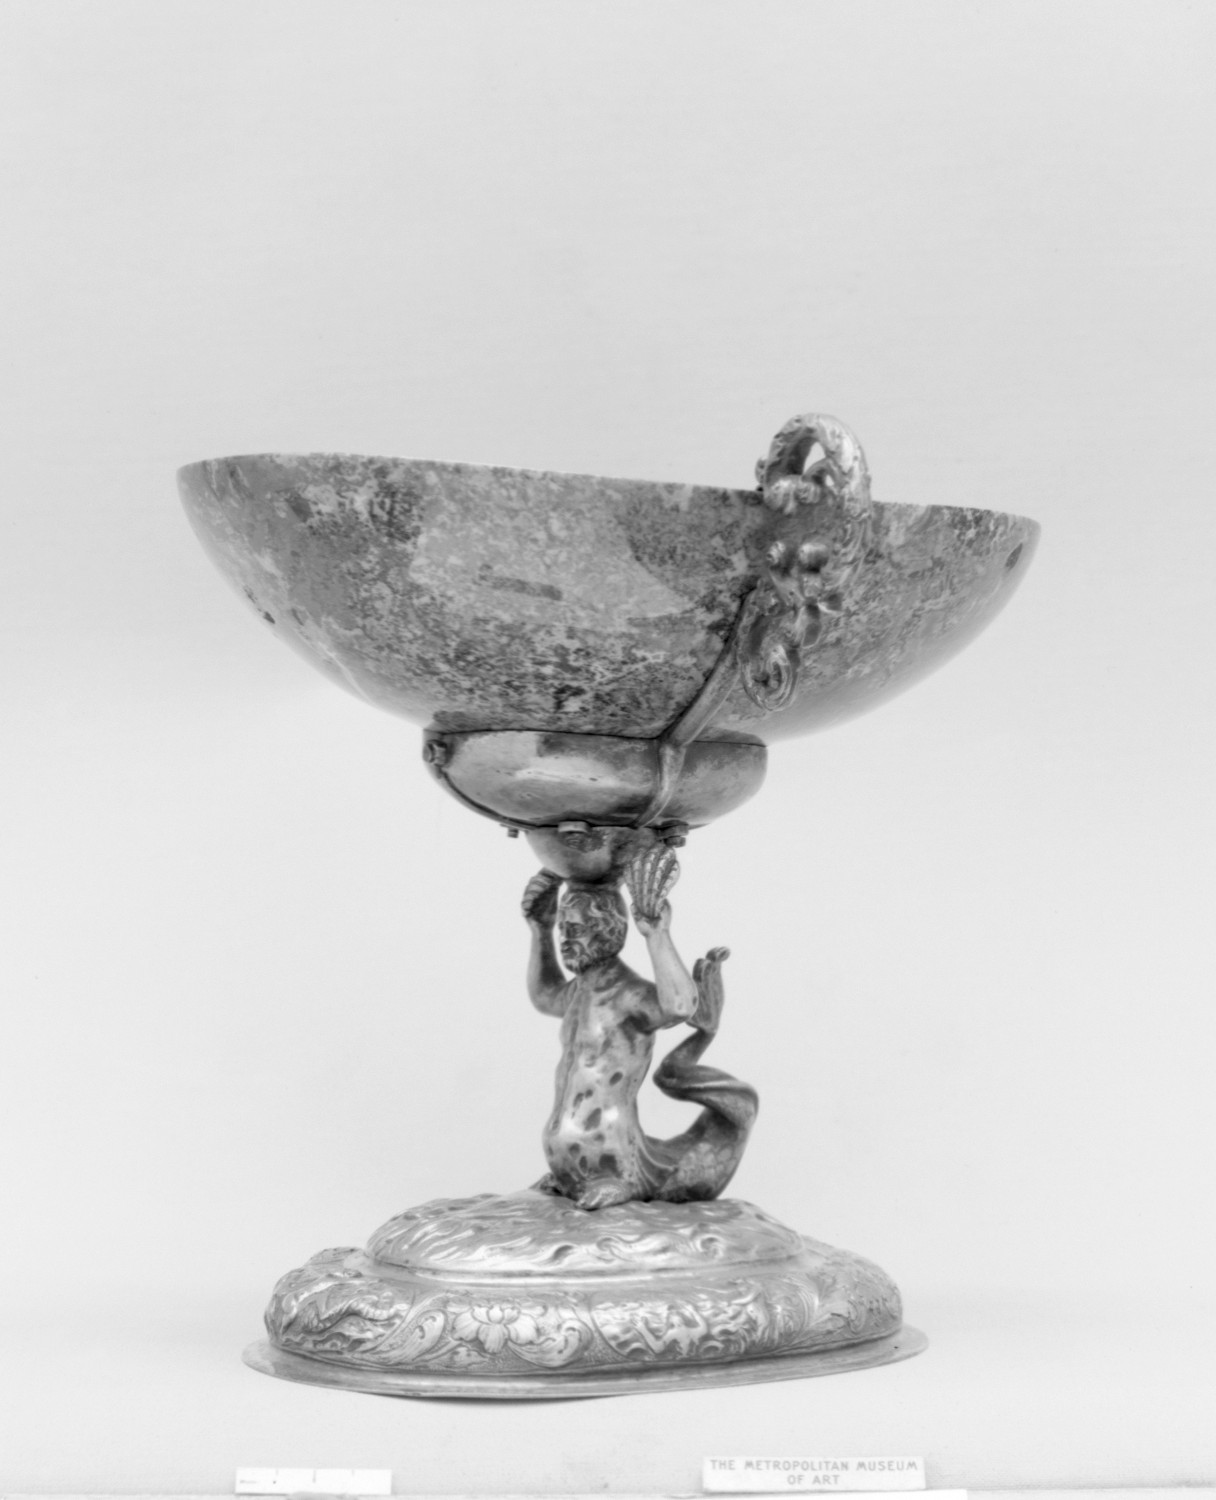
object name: cup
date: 1701-1800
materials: stone, silver gilt